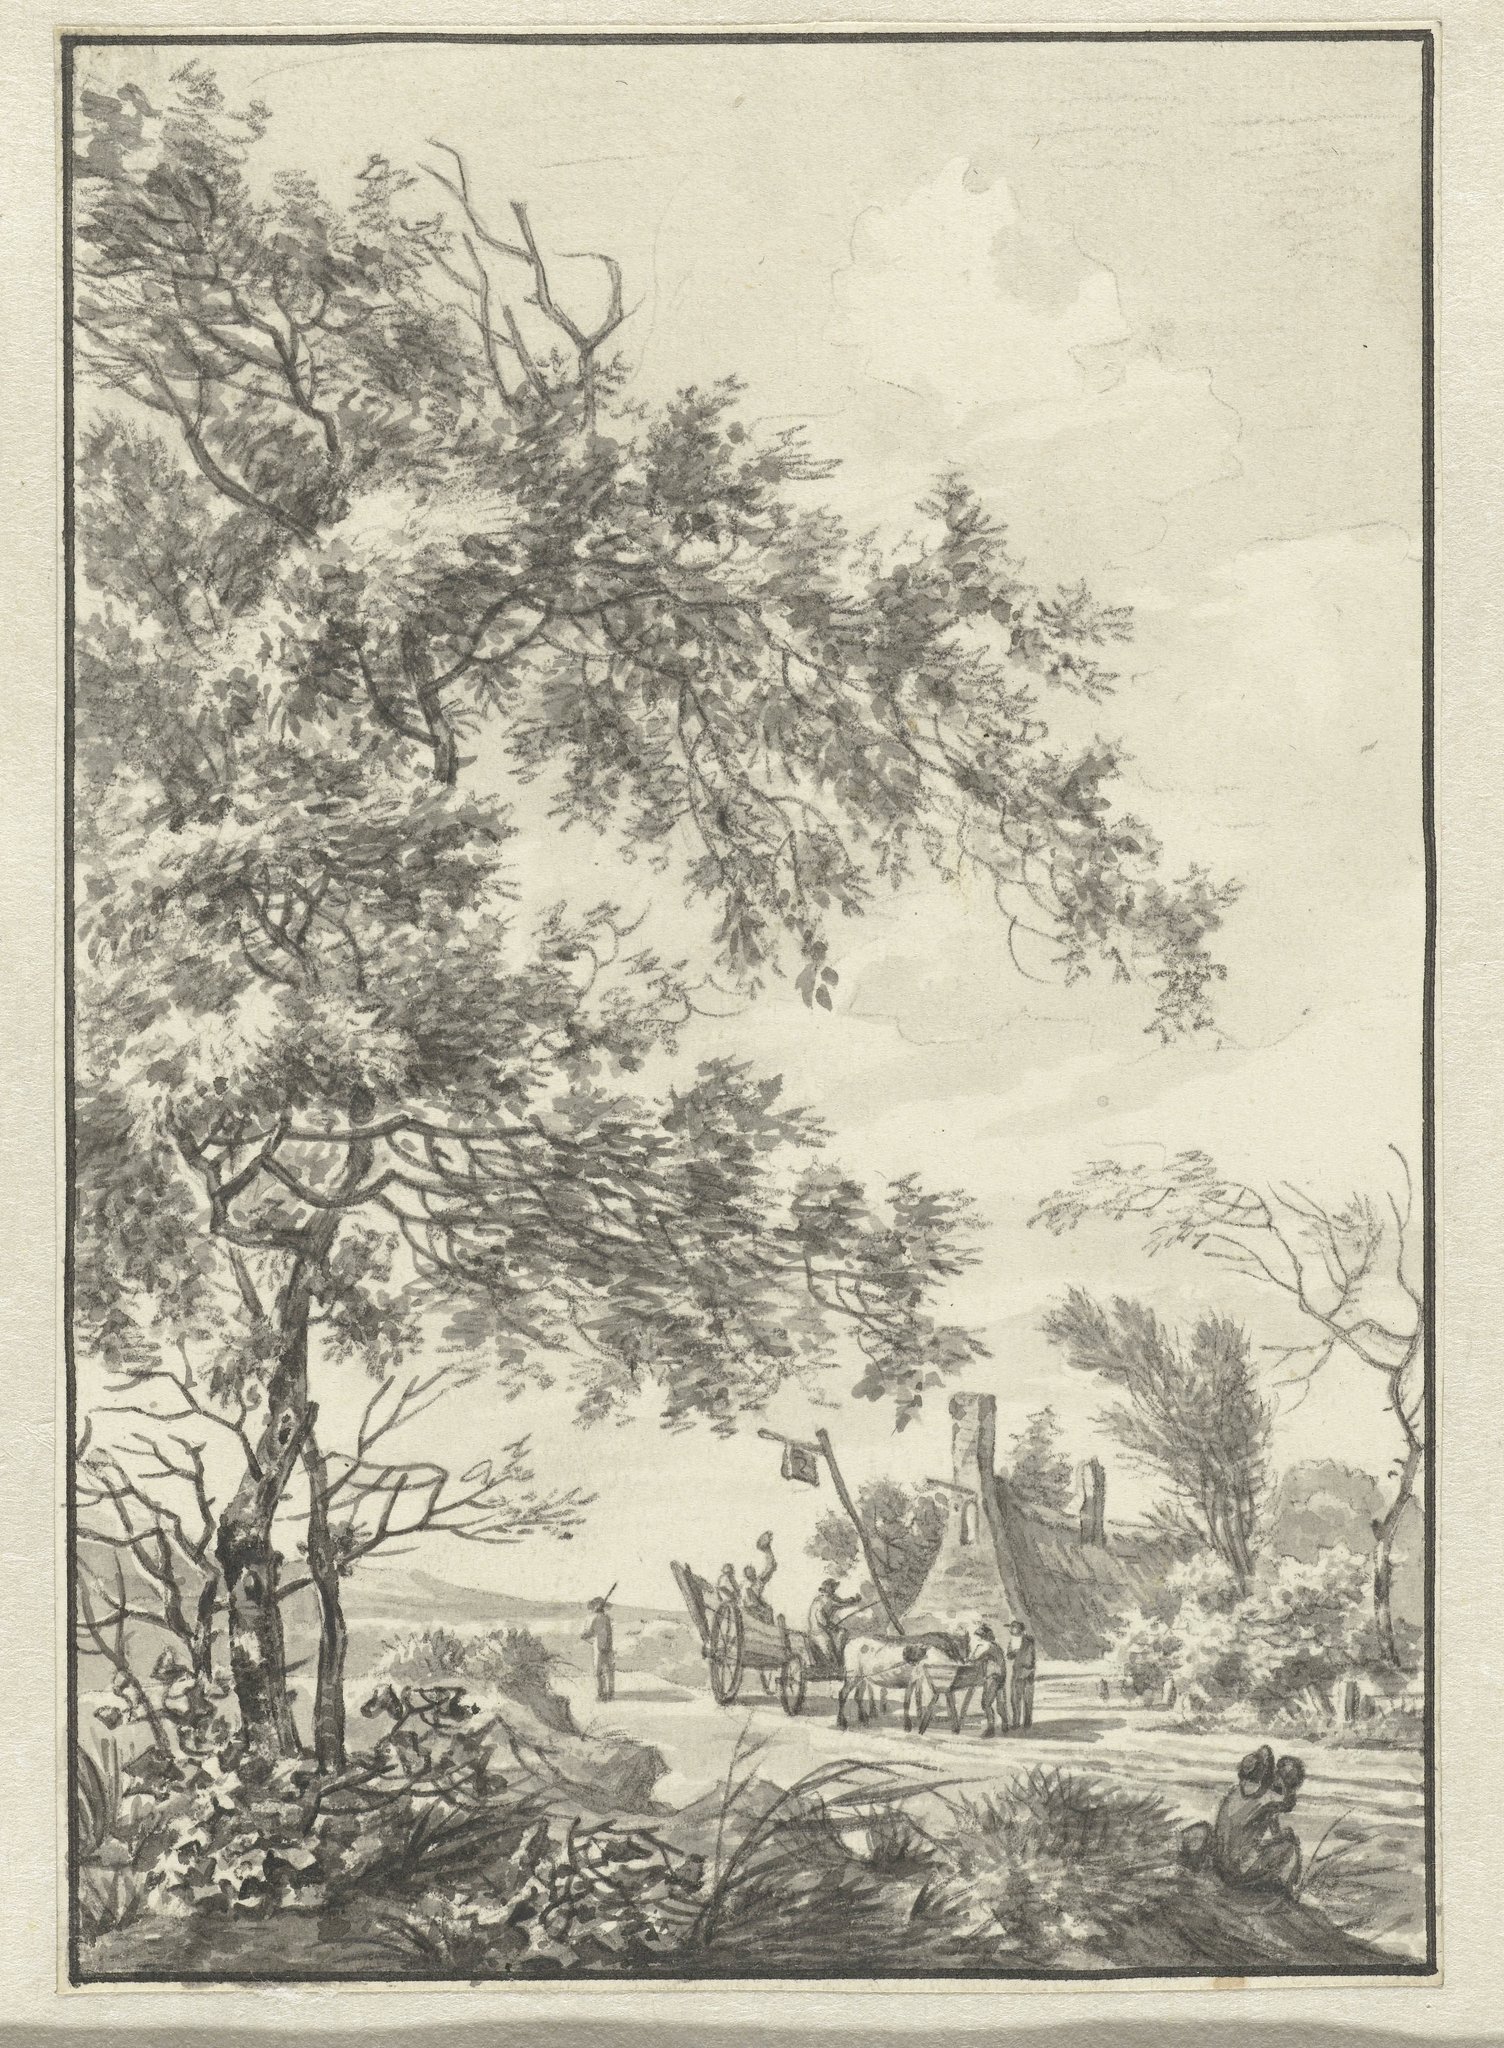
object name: drawing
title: Landschap met boerenwagen bij een herberg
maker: cornelis van dokkum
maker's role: draughtsman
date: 1800-1820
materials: chalk, paper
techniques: brush